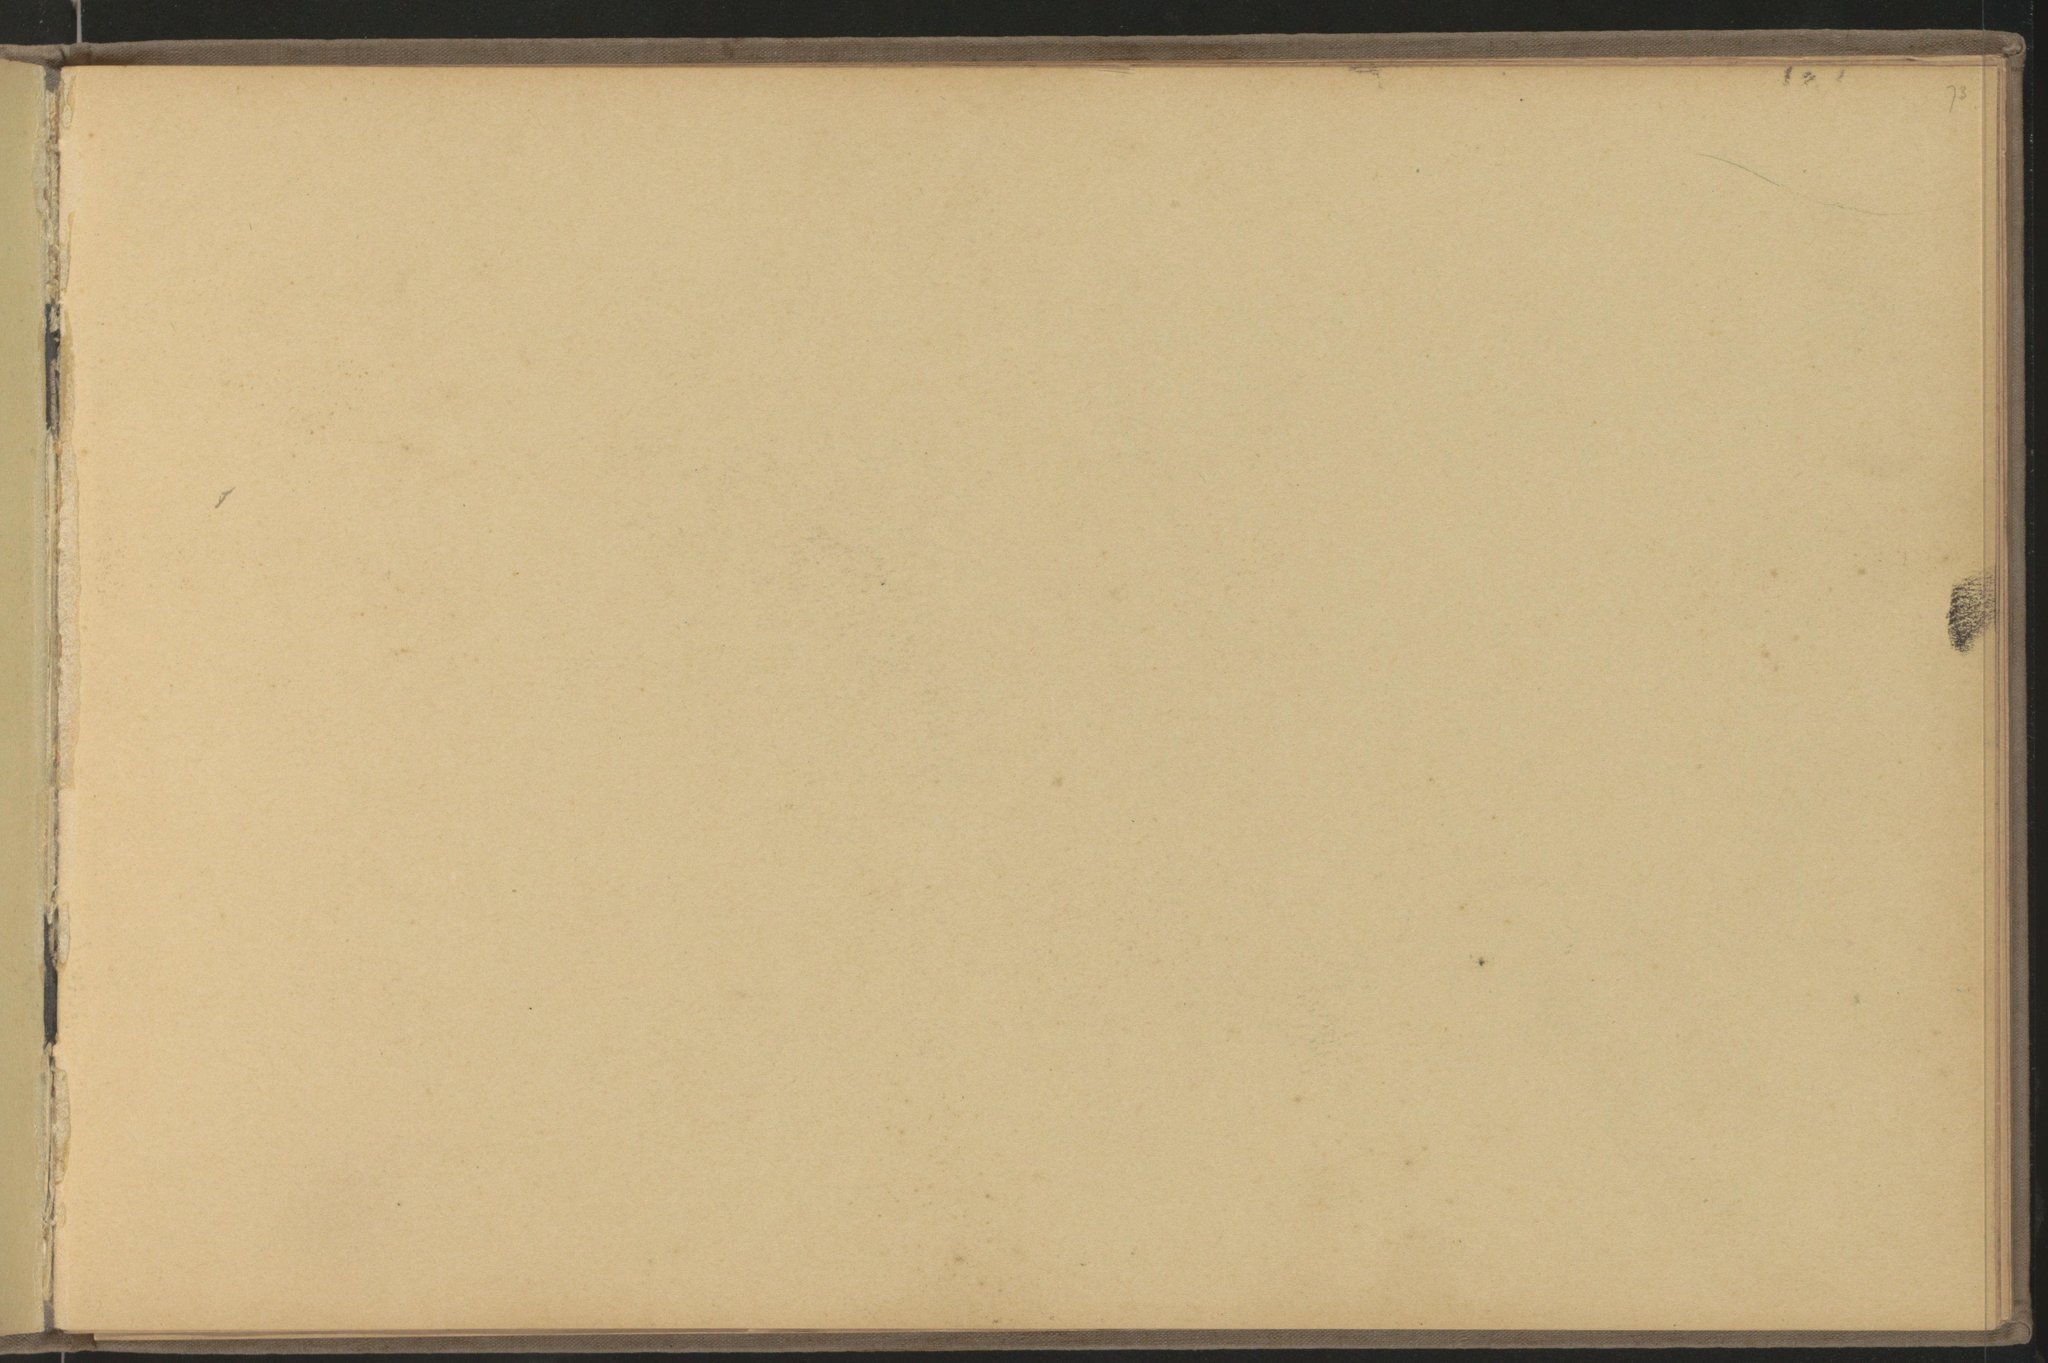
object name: sketchbook leaf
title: Studie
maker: willem witsen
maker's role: draughtsman, painter, print maker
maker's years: 1860-1923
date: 1901-1907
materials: chalk, paper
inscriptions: kleurnotitie, handgeschreven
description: Pagina 73 uit een schetsboek met 60 bladen.